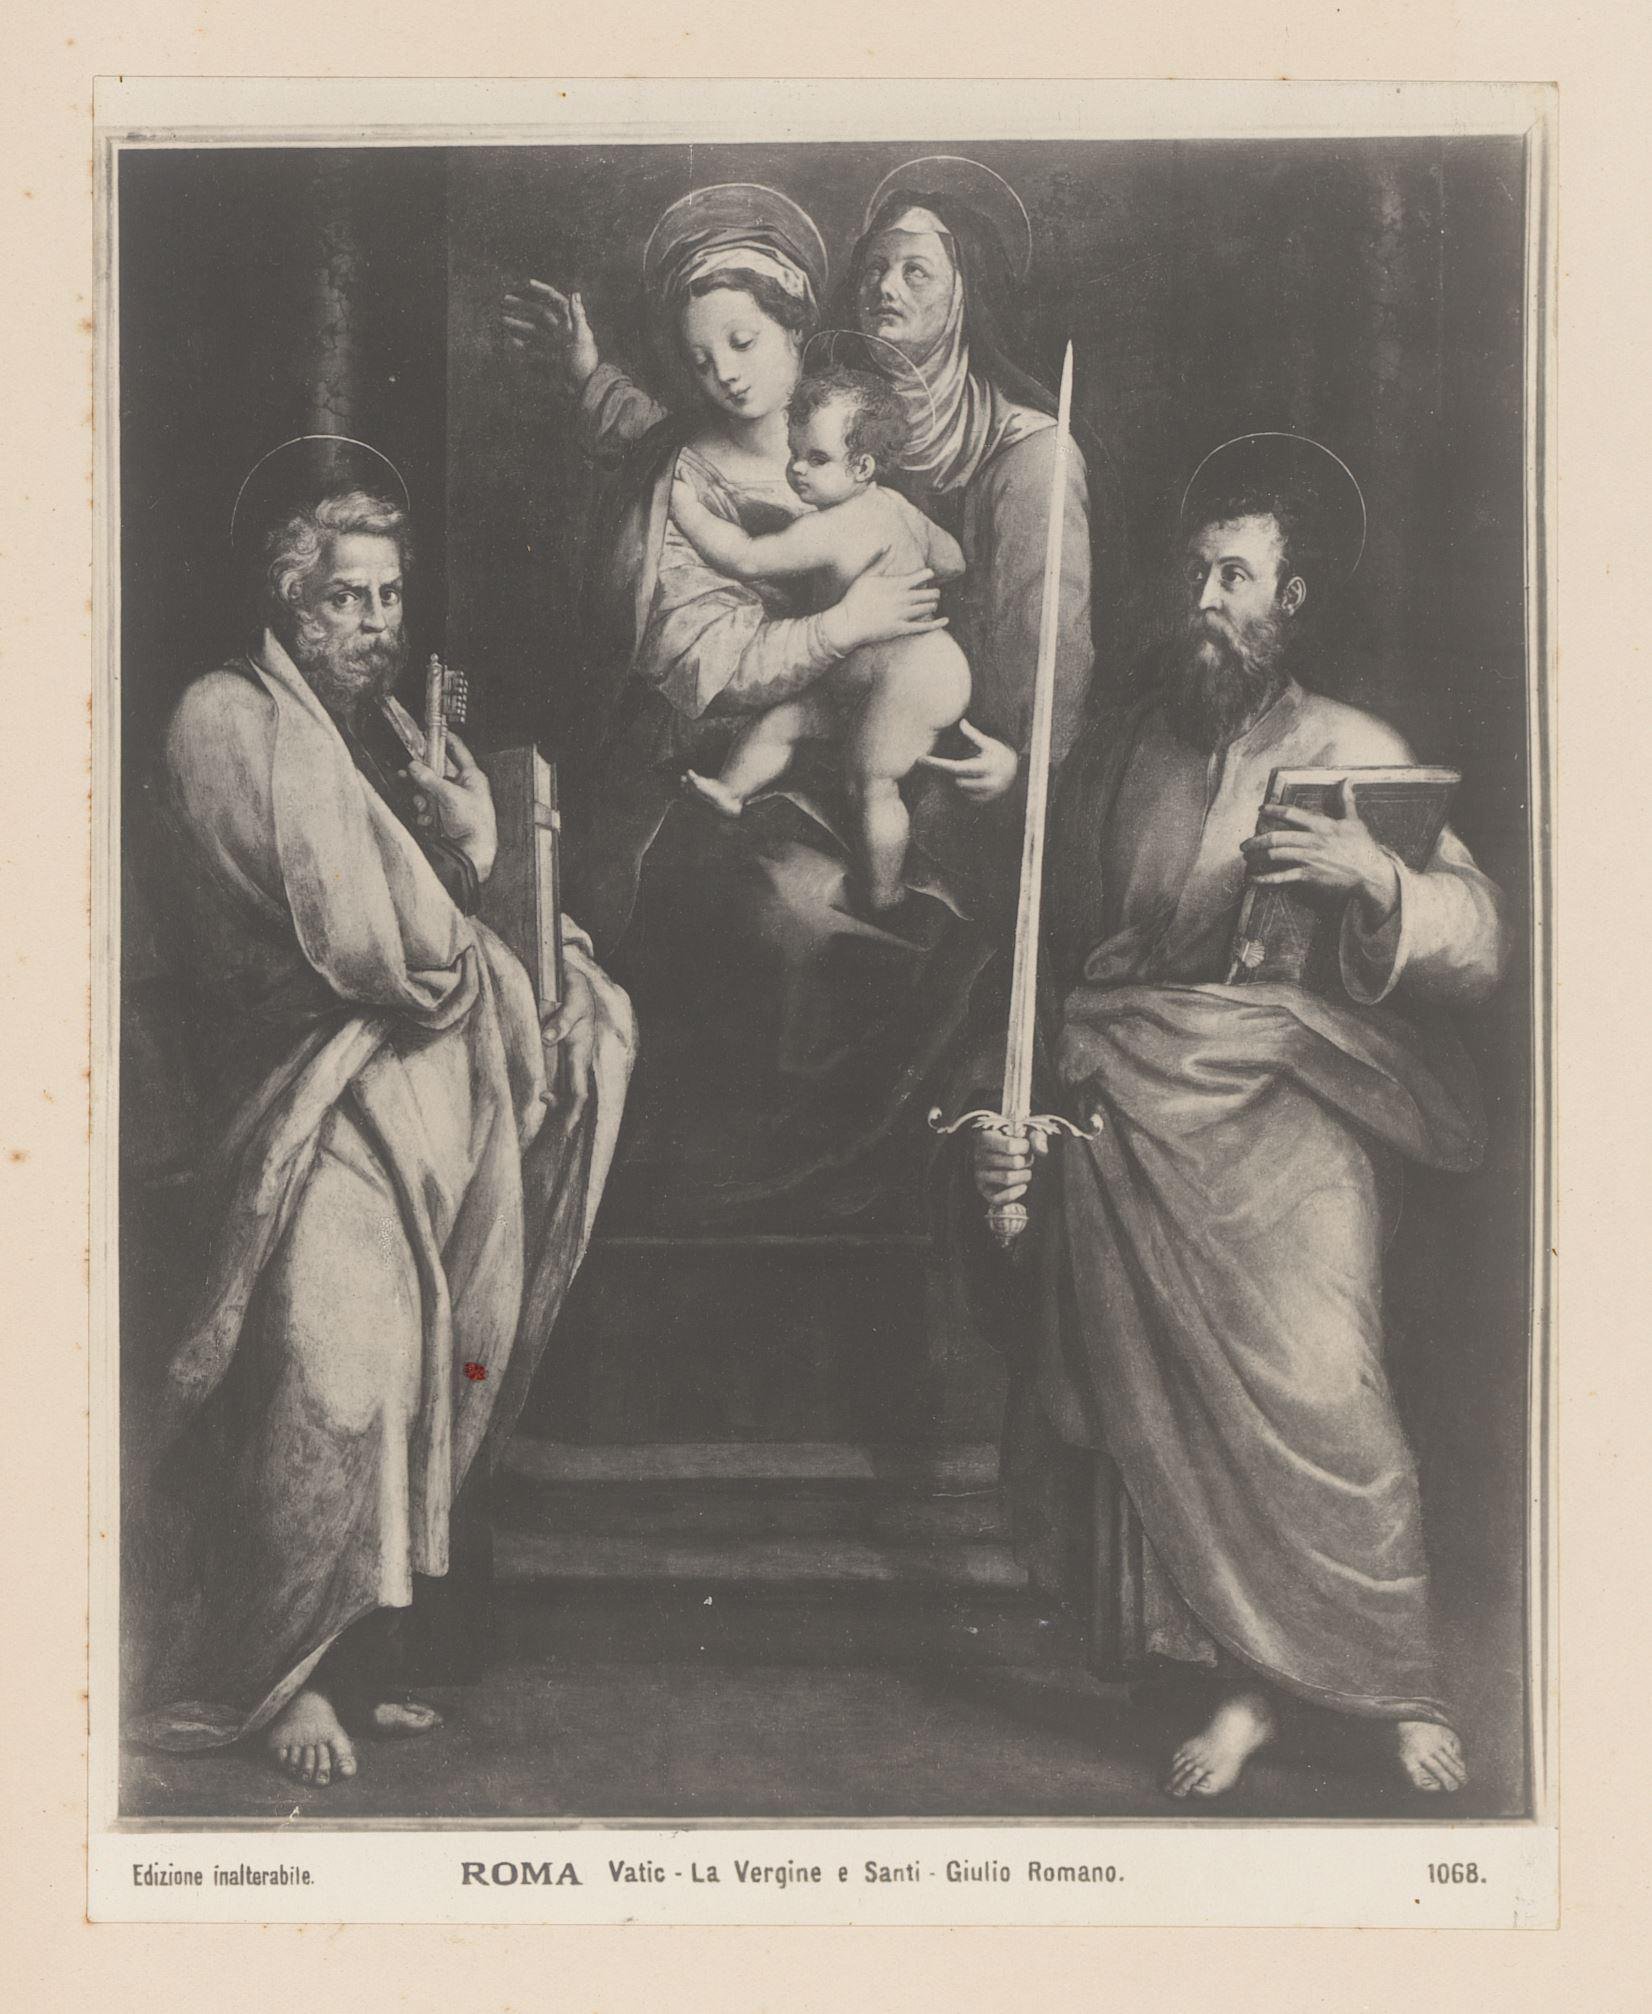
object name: album leaf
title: La Verique e Santi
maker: Anonymous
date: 1890-1920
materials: paper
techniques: gelatin silver print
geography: vatican museums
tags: madonna accompanied by saint(s), picture, painting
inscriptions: inscription: ‘Edizione inalterabile. ROMA Vatic - La Verique e Santi - Giulio Romano. 1068.’